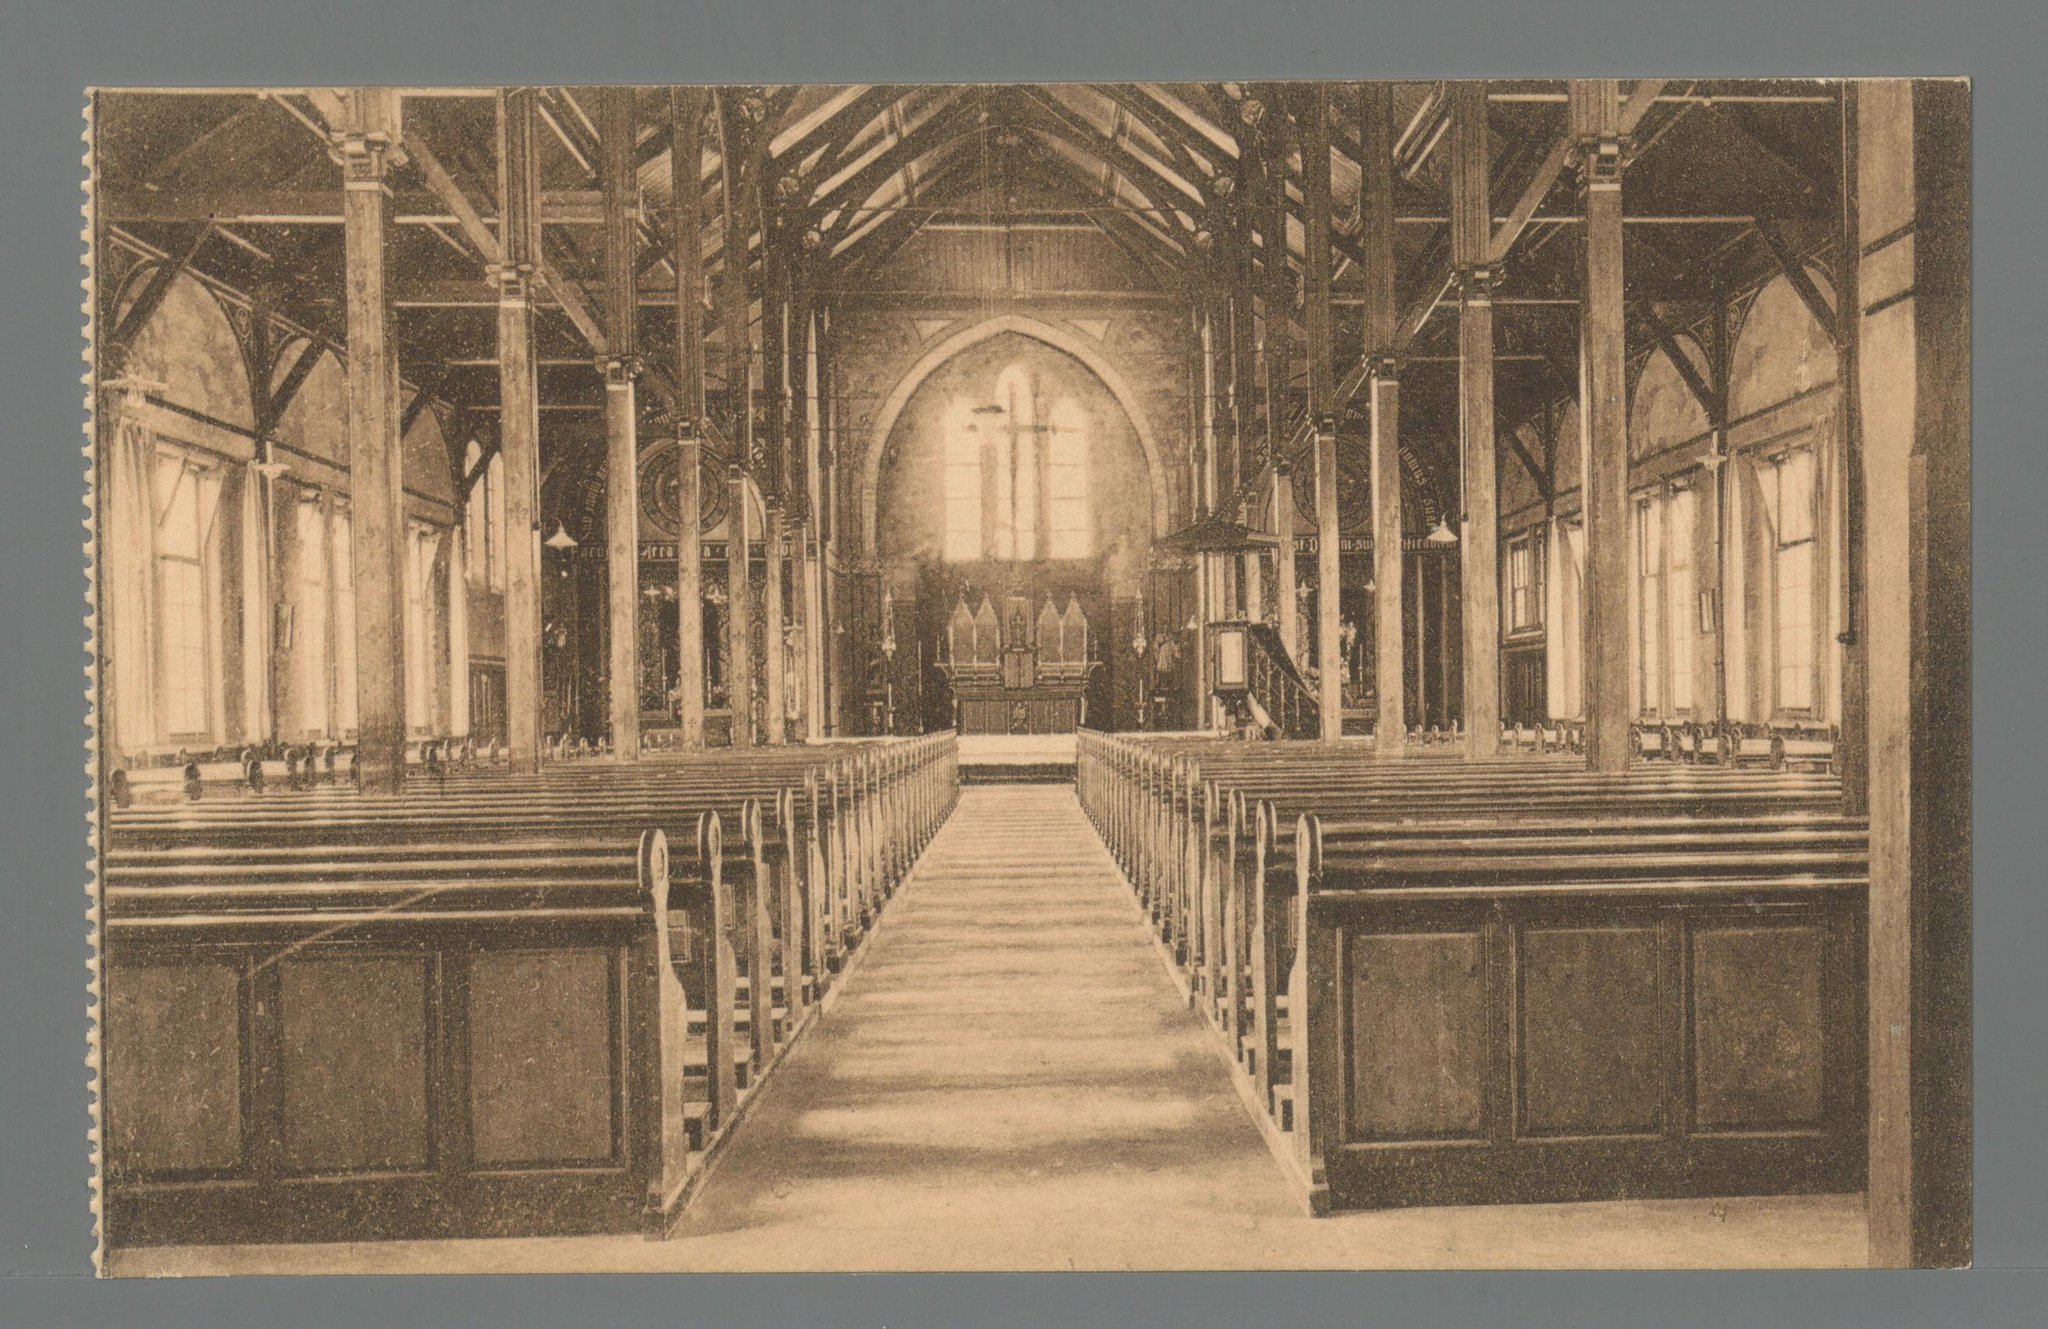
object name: photomechanical print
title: Interieur der Parochiekerk St. Aloysius, Utrecht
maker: Anonymous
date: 1905-1930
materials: cardboard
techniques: photograph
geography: utrecht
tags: interior of church